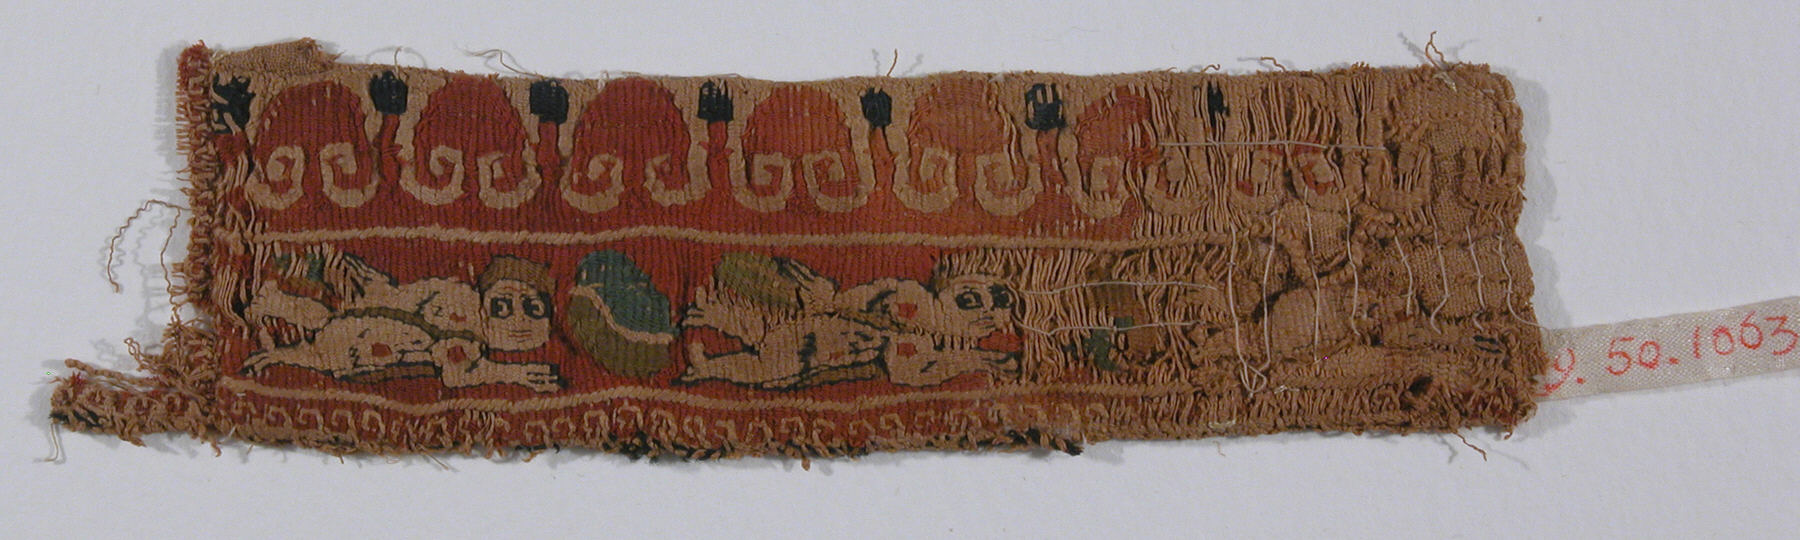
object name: band fragment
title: Fragment of a Band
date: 401-600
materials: linen, wool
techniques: weave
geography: egypt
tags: mythical creatures